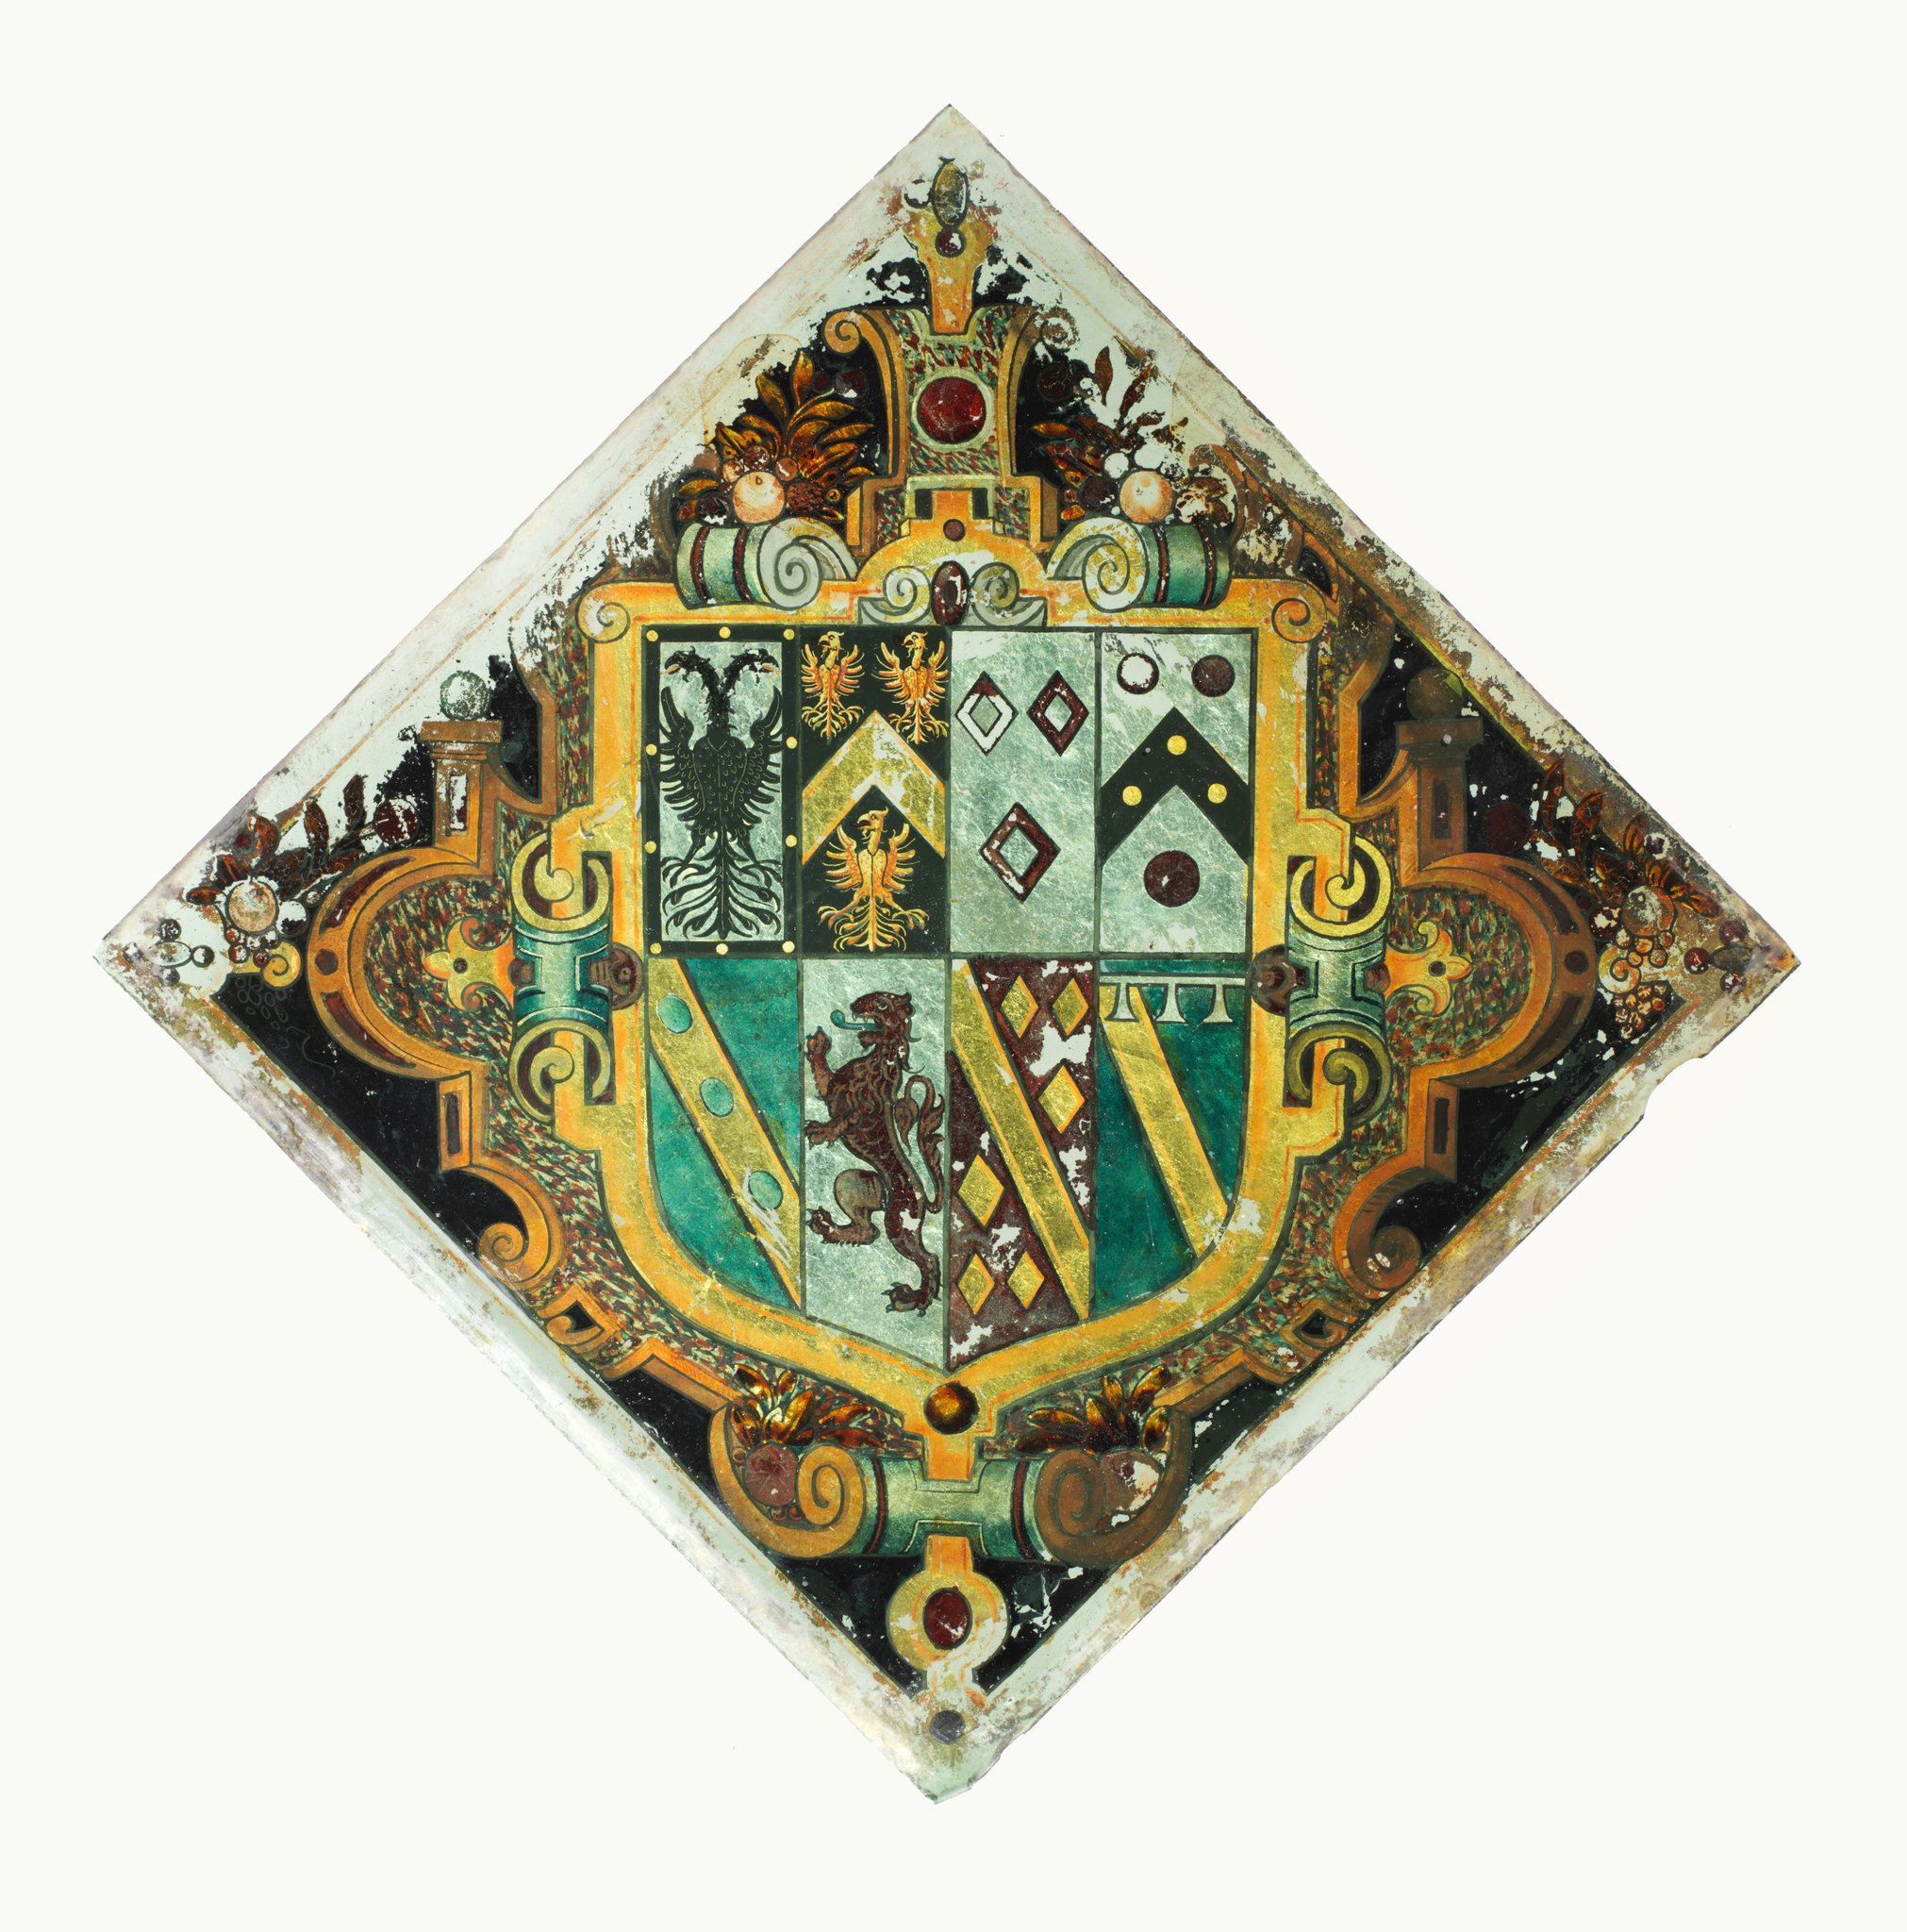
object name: panel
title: Panel with arms of the Killigrew family of Cornwall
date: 1570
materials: glass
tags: coat of arms